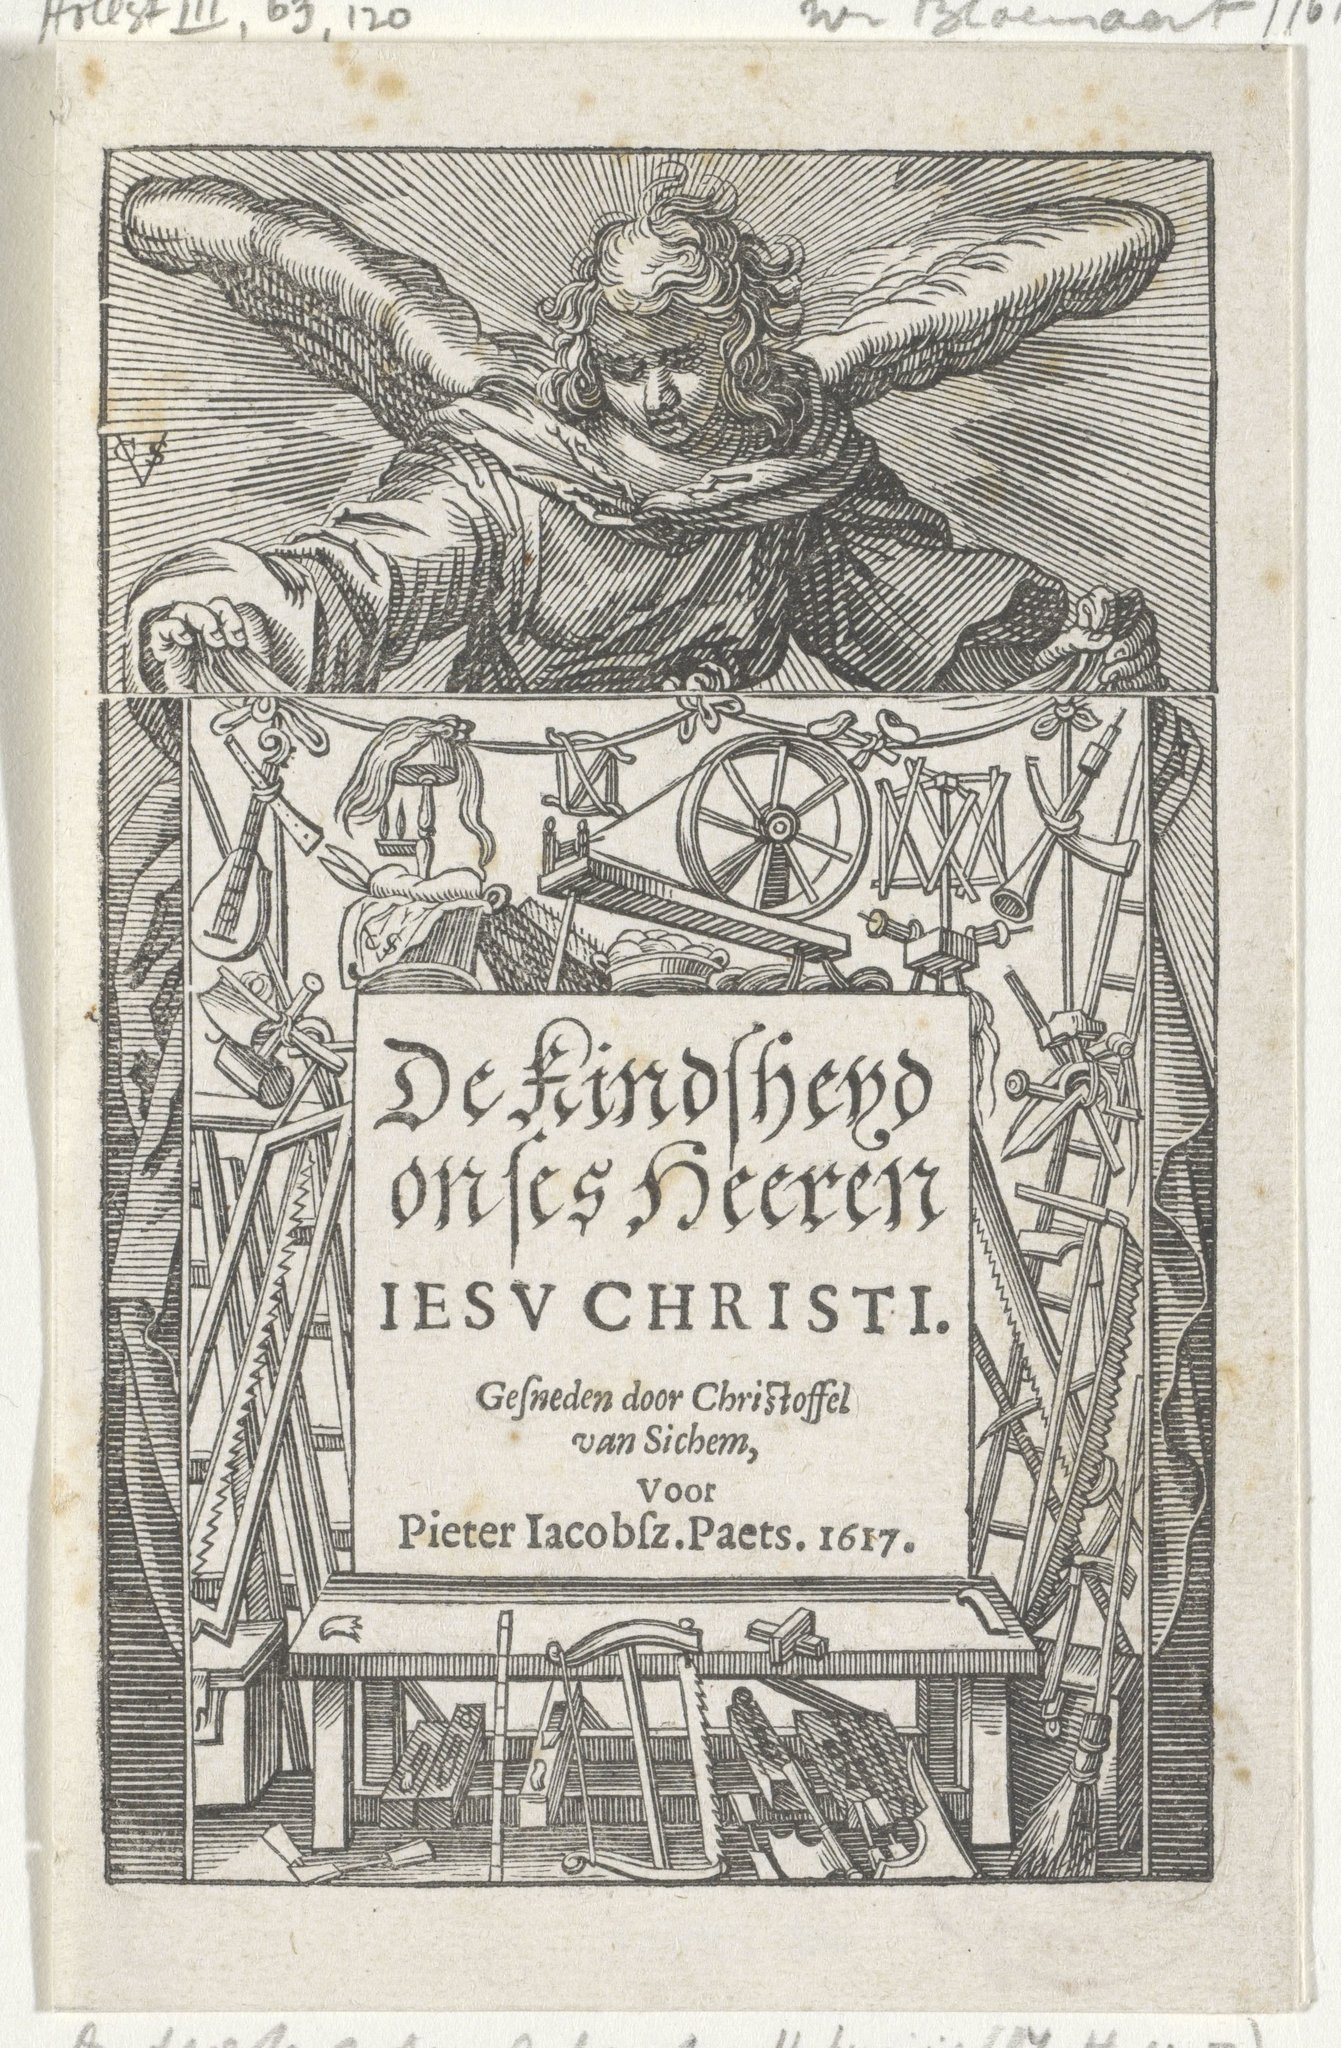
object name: print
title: Jeugd van Christus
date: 1617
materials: paper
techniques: letterpress printing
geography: amsterdam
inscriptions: collector's mark: Lugt 240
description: Een engel houdt een doek vast met daarop verschillende huishoudelijke objecten en timmermanswerktuigen, waaronder een spinnewiel, een bezem, een aantal hamers en zagen.